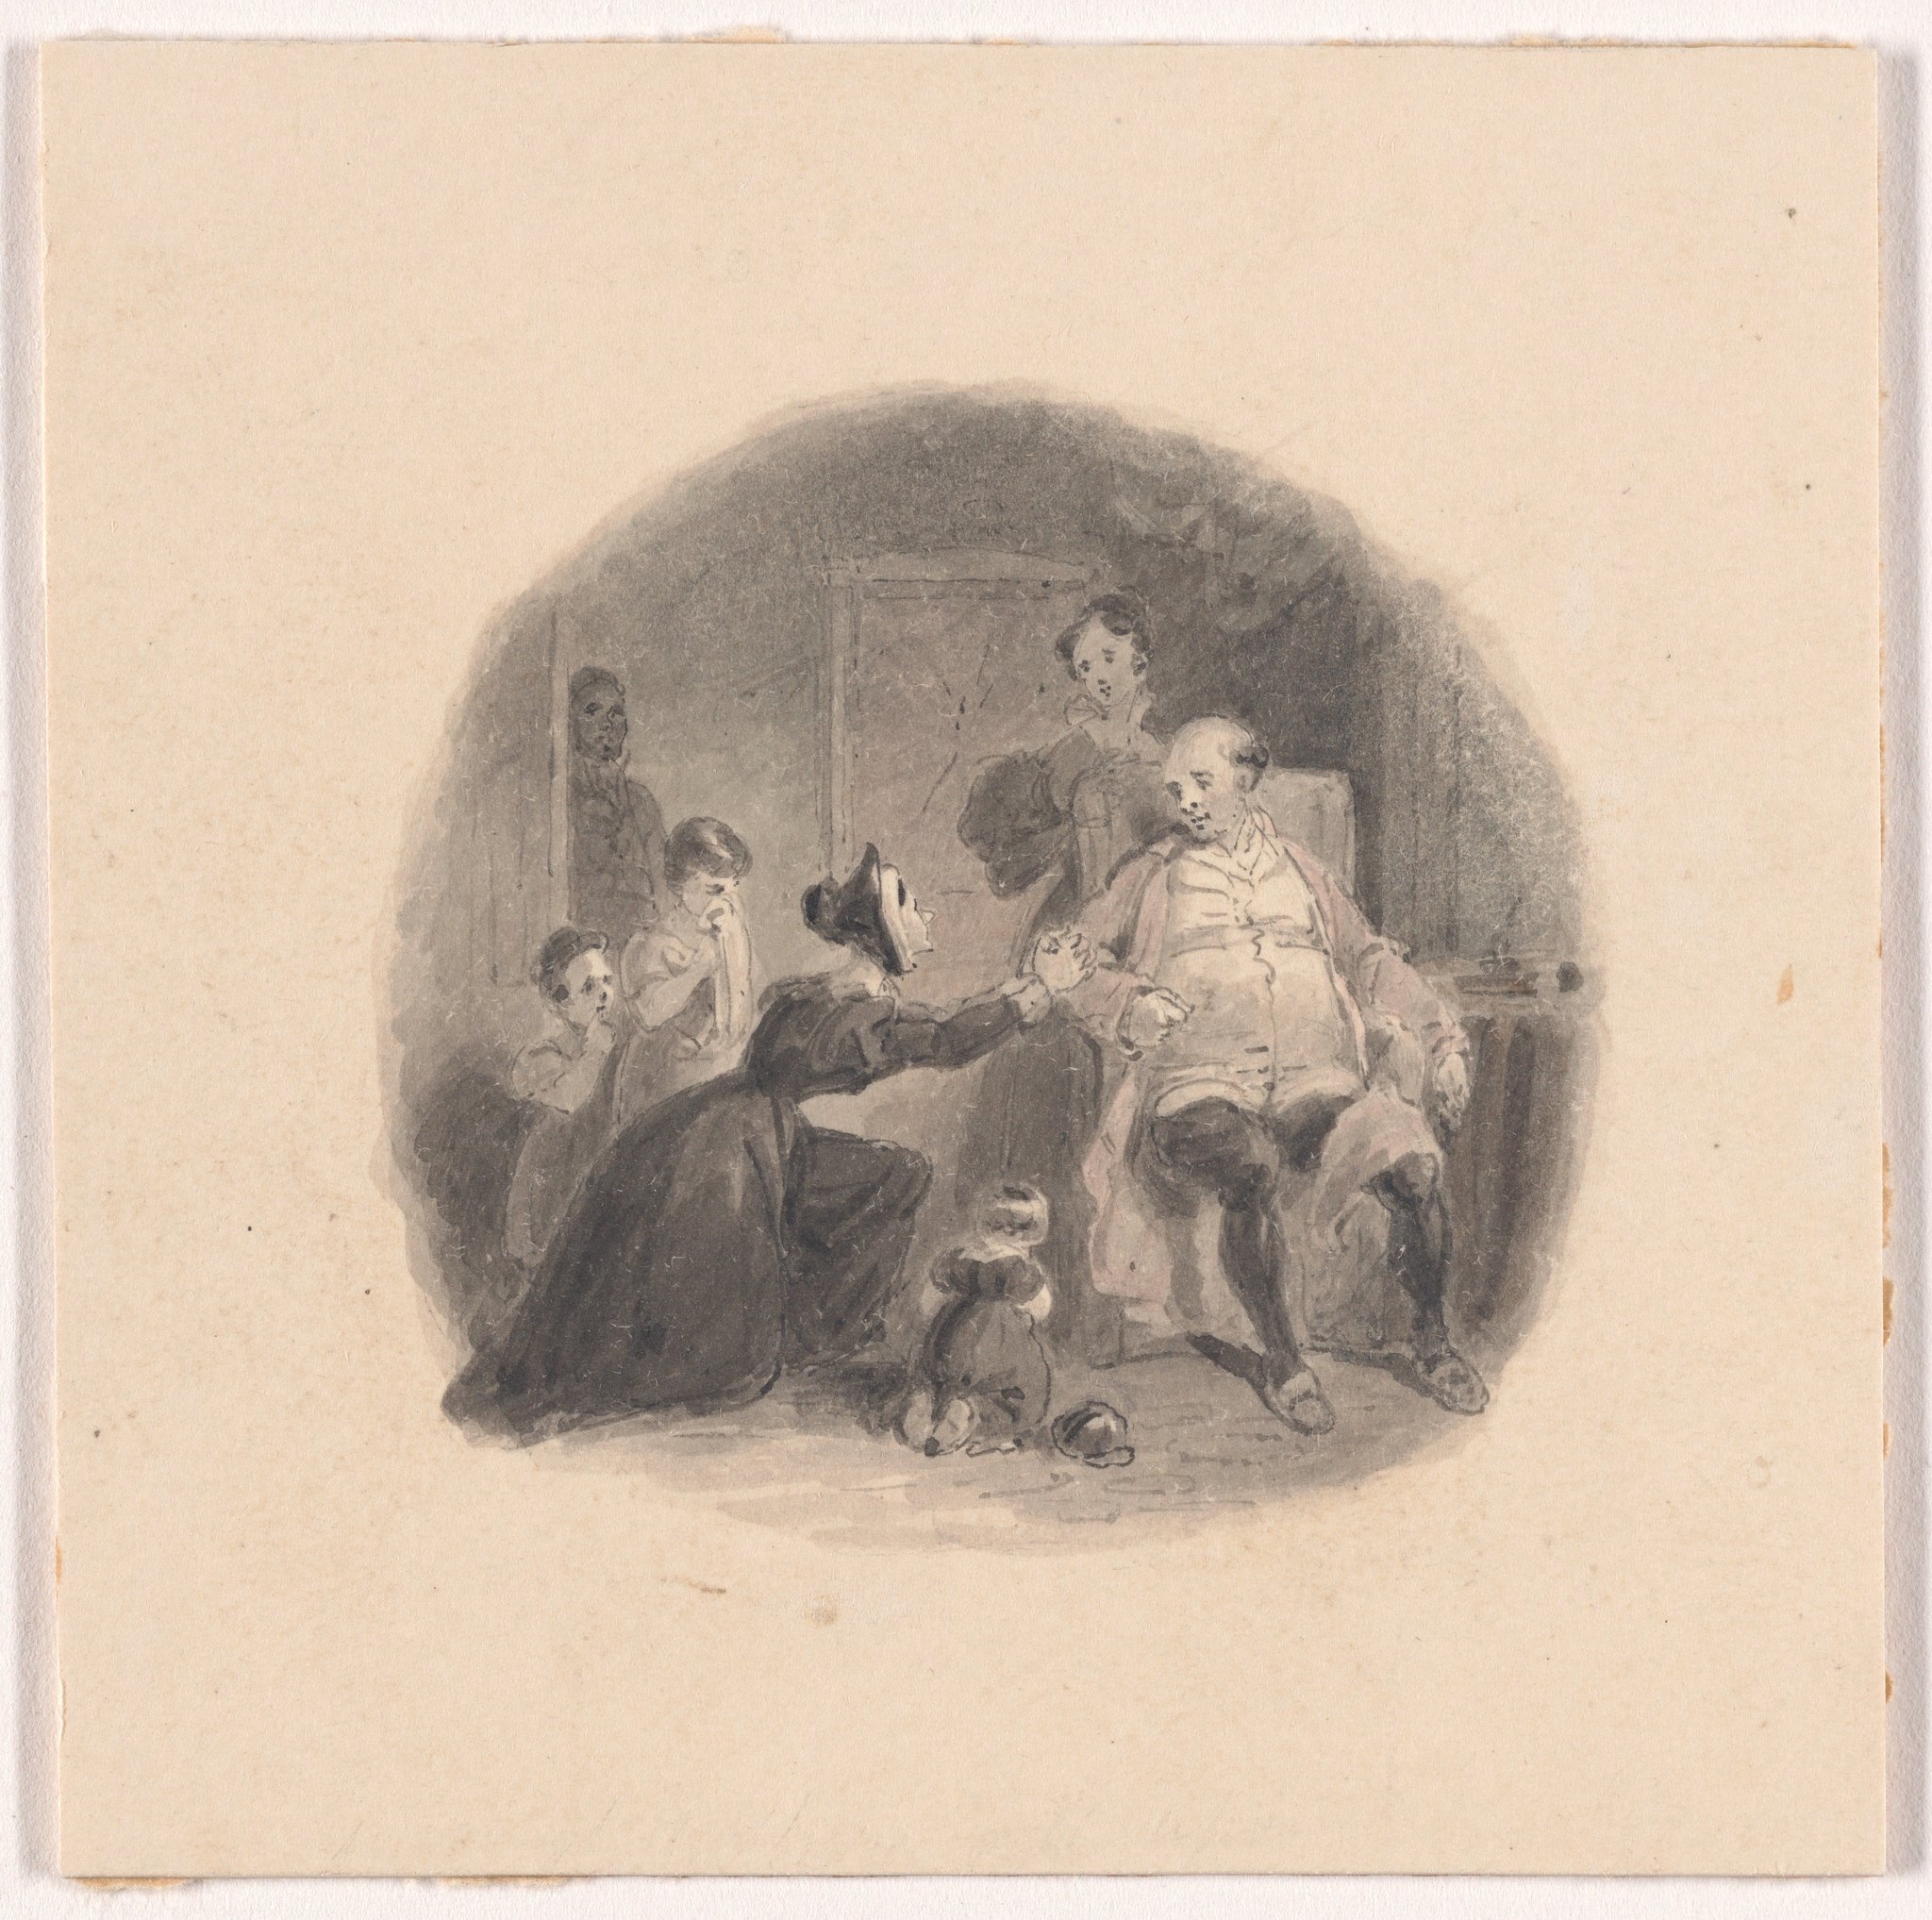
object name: drawing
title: Illustration design for "The Economy of Human Life"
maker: frank howard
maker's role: artist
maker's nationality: british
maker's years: 1805-1866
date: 1834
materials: ink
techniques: brush, pen, wash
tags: children,men,women